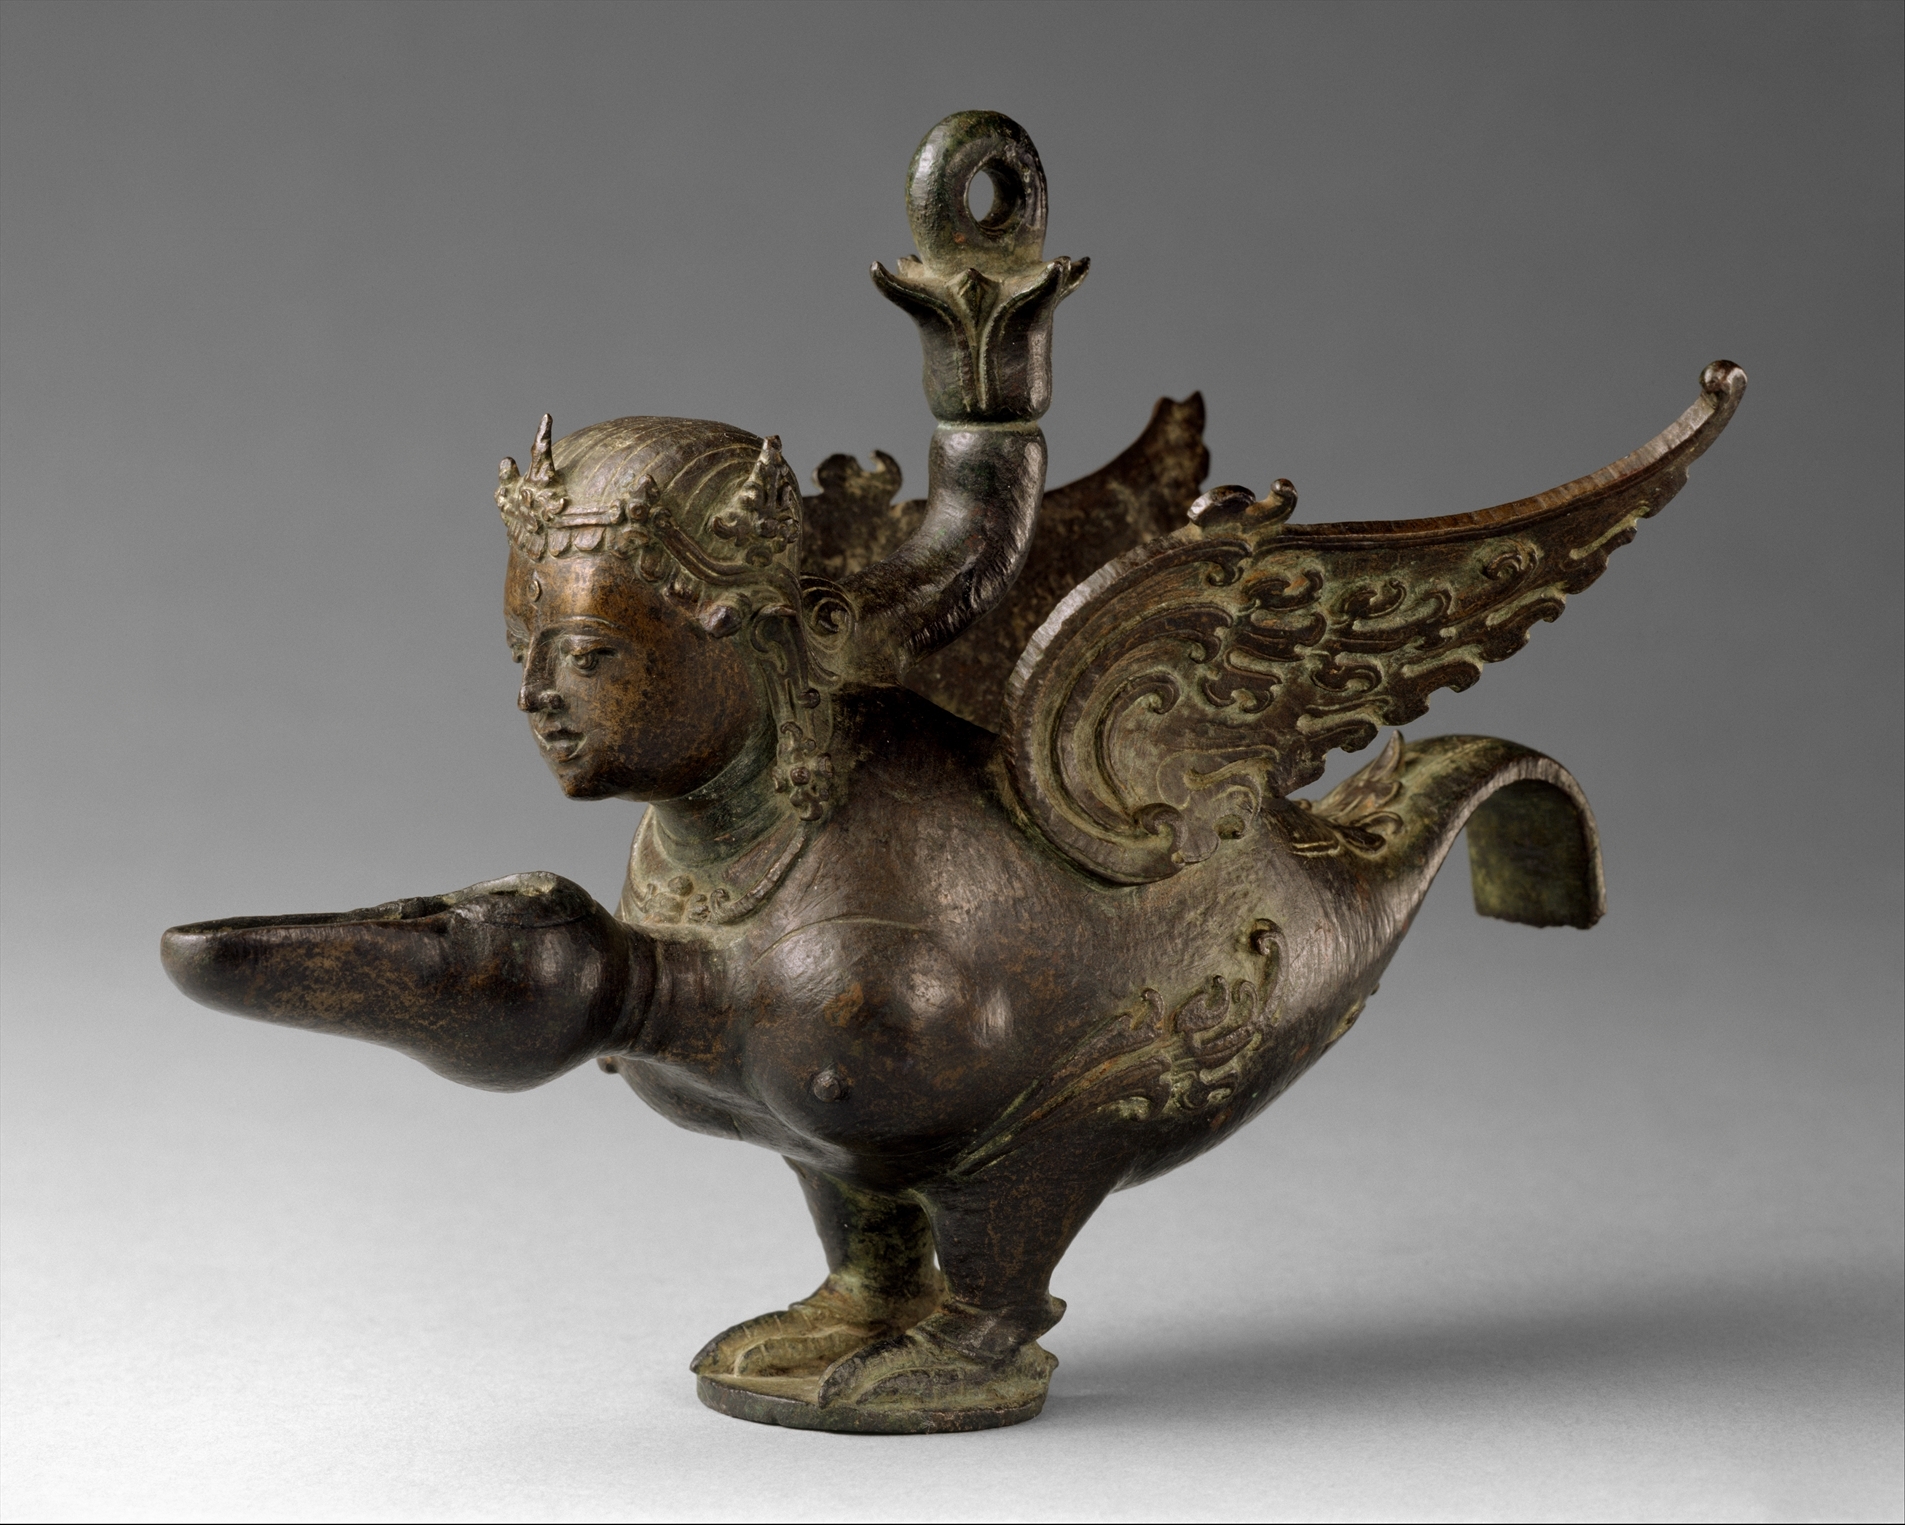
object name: hanging lamp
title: Hanging Lamp in the Form of a Kinnari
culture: indonesian, javanese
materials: bronze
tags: mythical creatures